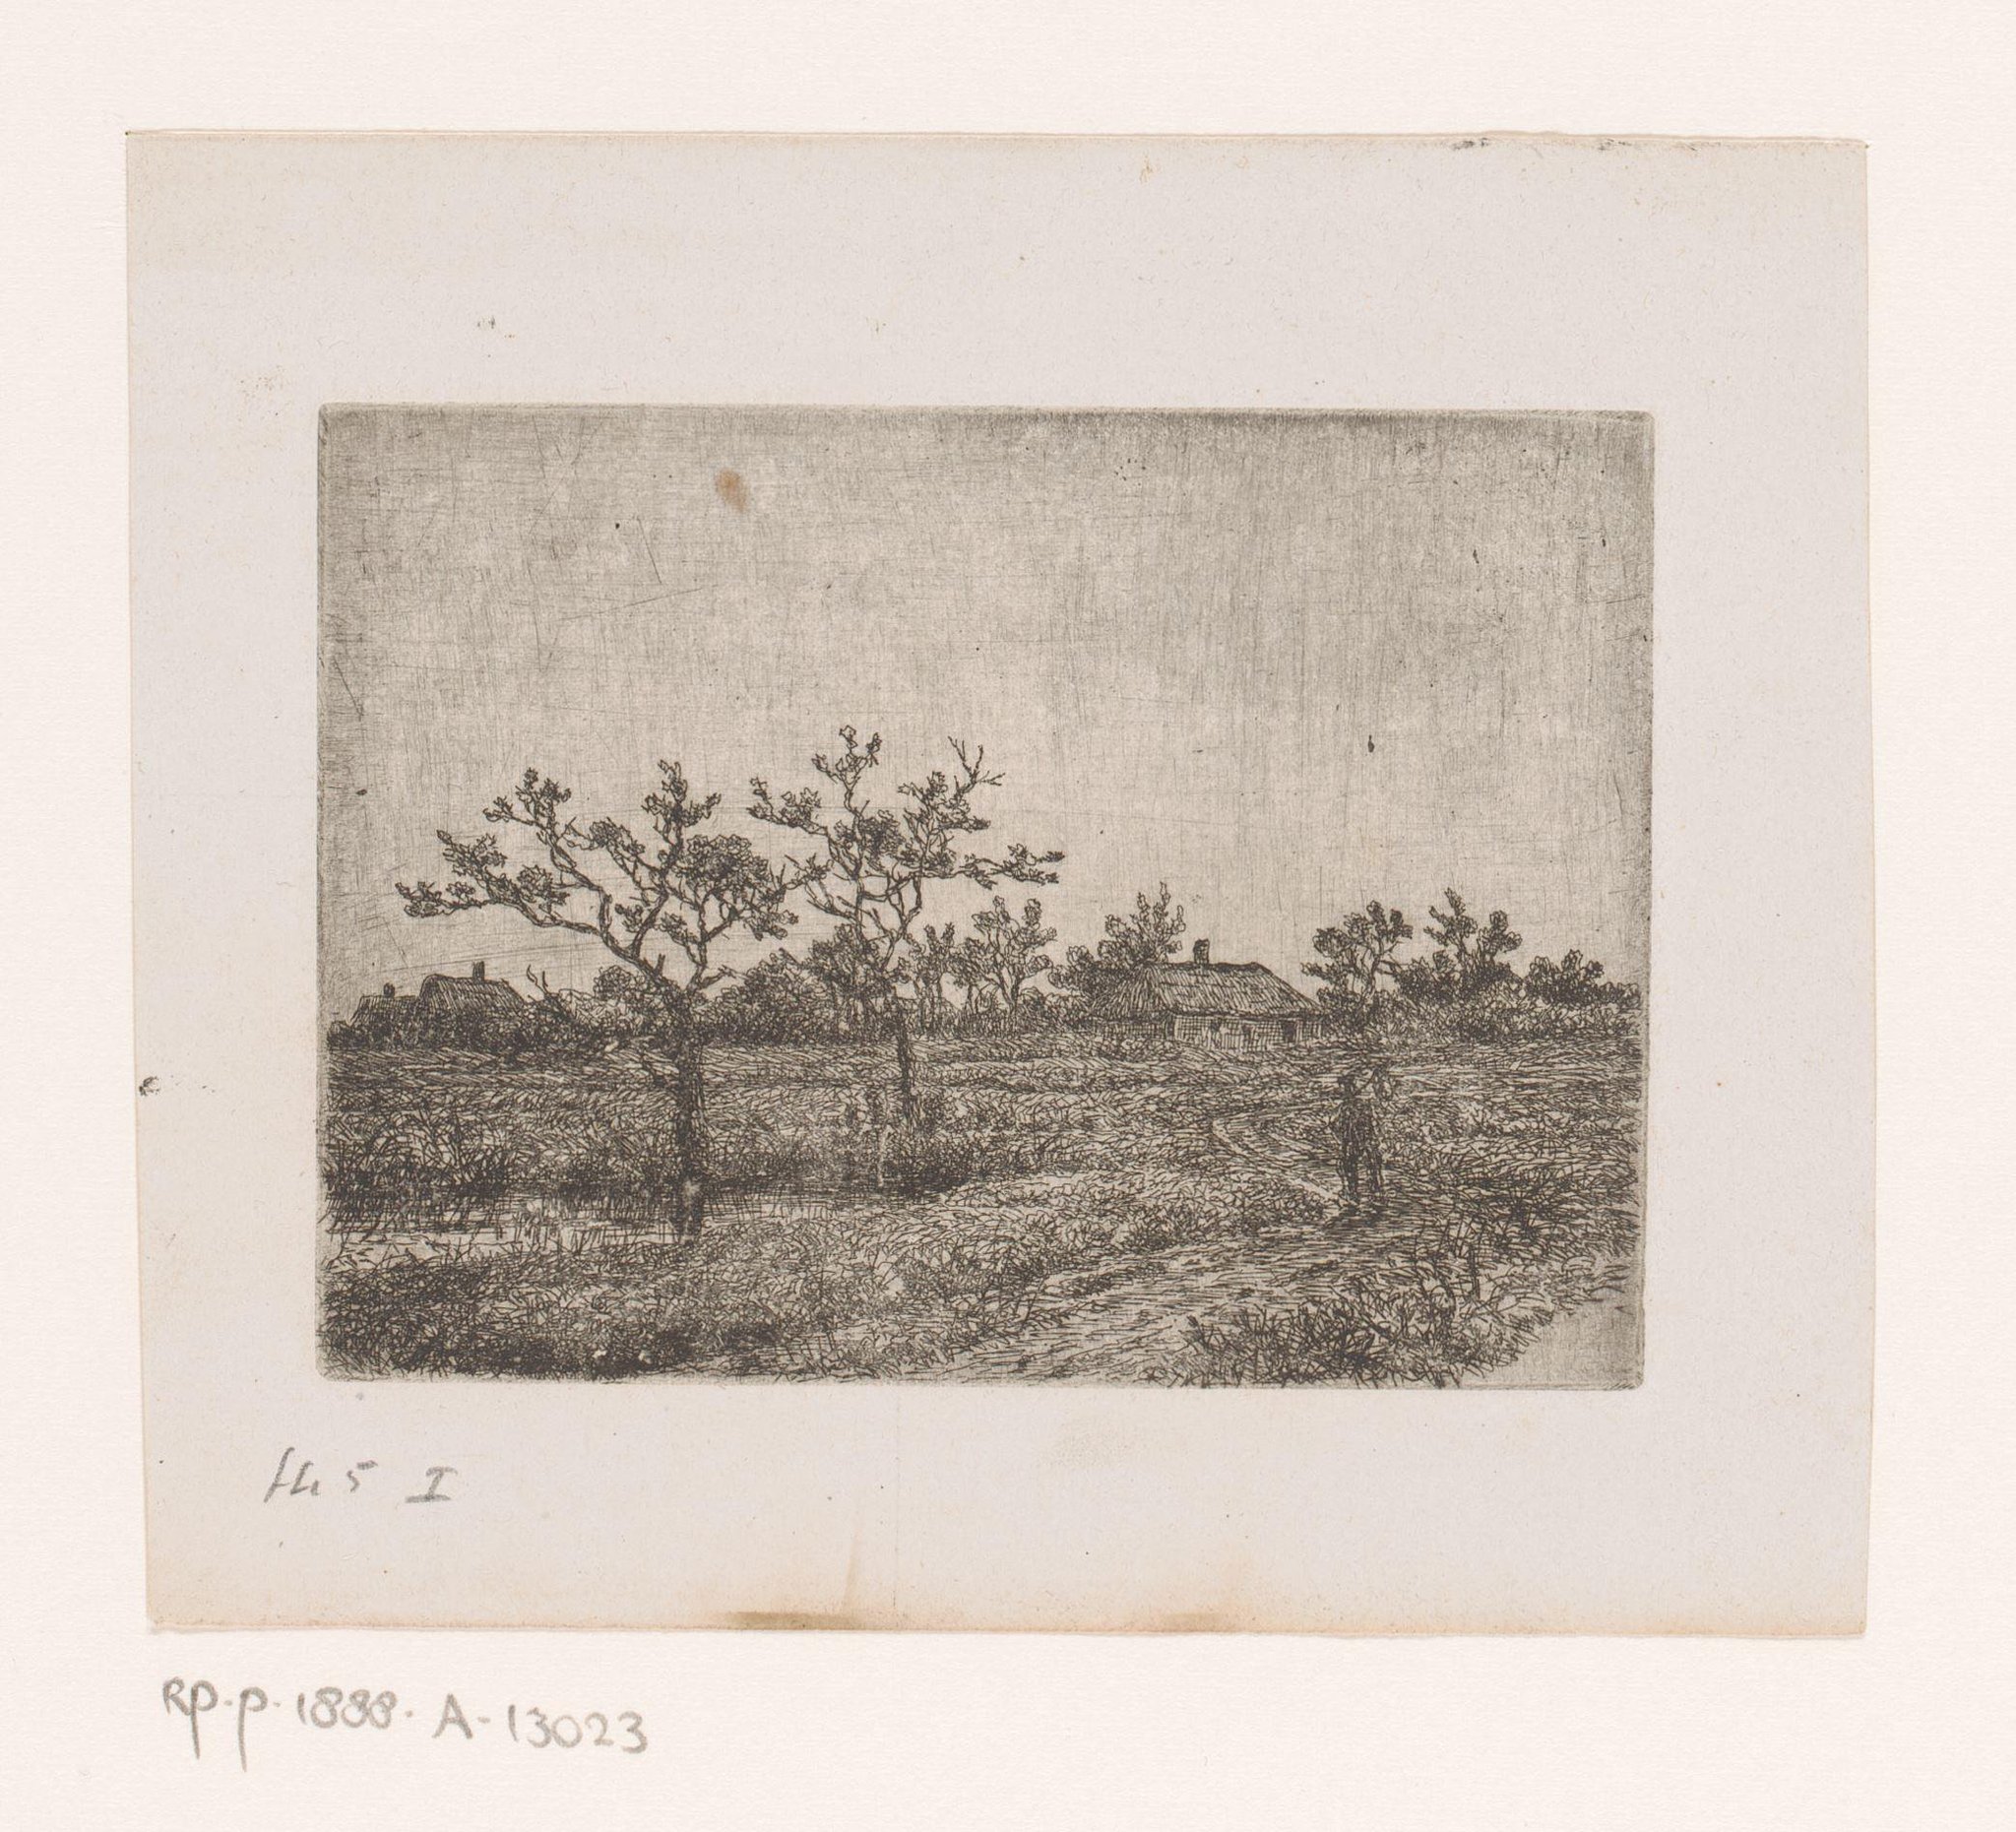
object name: print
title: Landschap in de buurt van Antwerpen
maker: jean pierre françois lamorinière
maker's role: print maker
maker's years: 1828-1911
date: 1838-1888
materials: paper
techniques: etching, intaglio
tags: landscapes in the temperate zone, farm or solitary house in landscape, antwerp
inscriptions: collector's mark: Lugt 2228